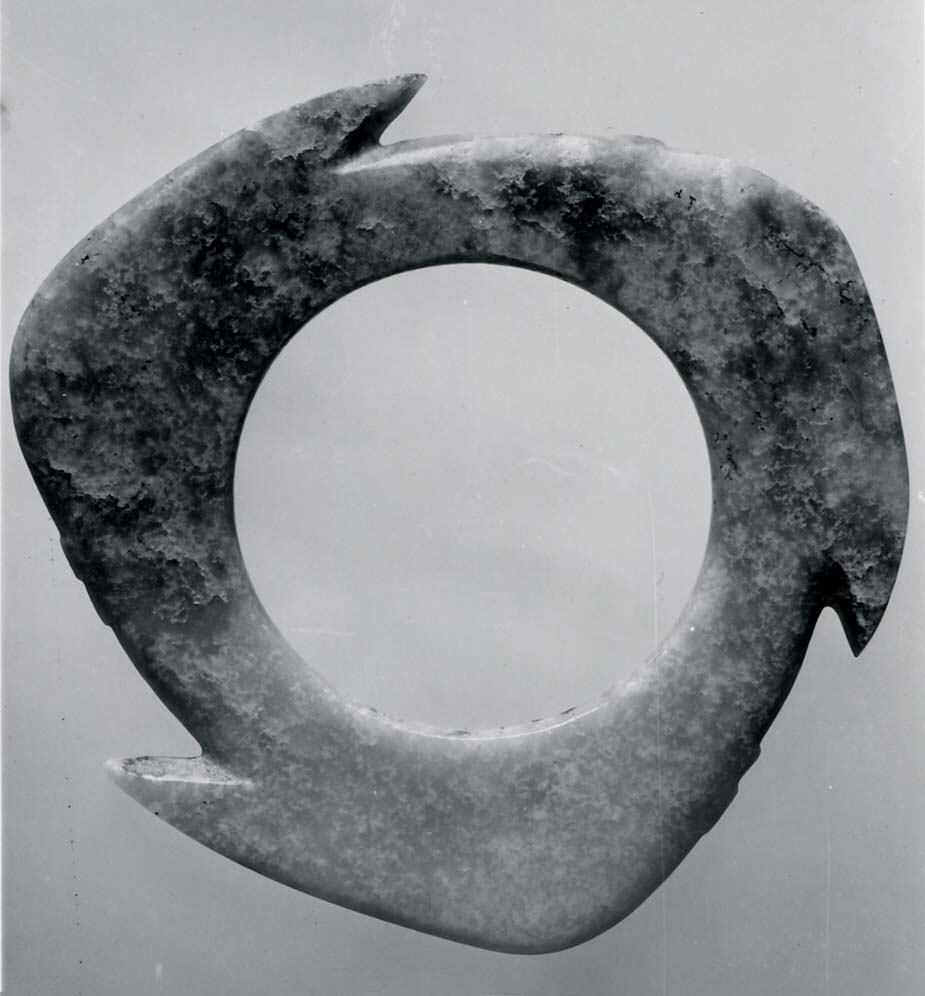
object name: disk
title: Notched Disk (Xuanji)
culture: chinese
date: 2400-2000 BCE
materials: jade